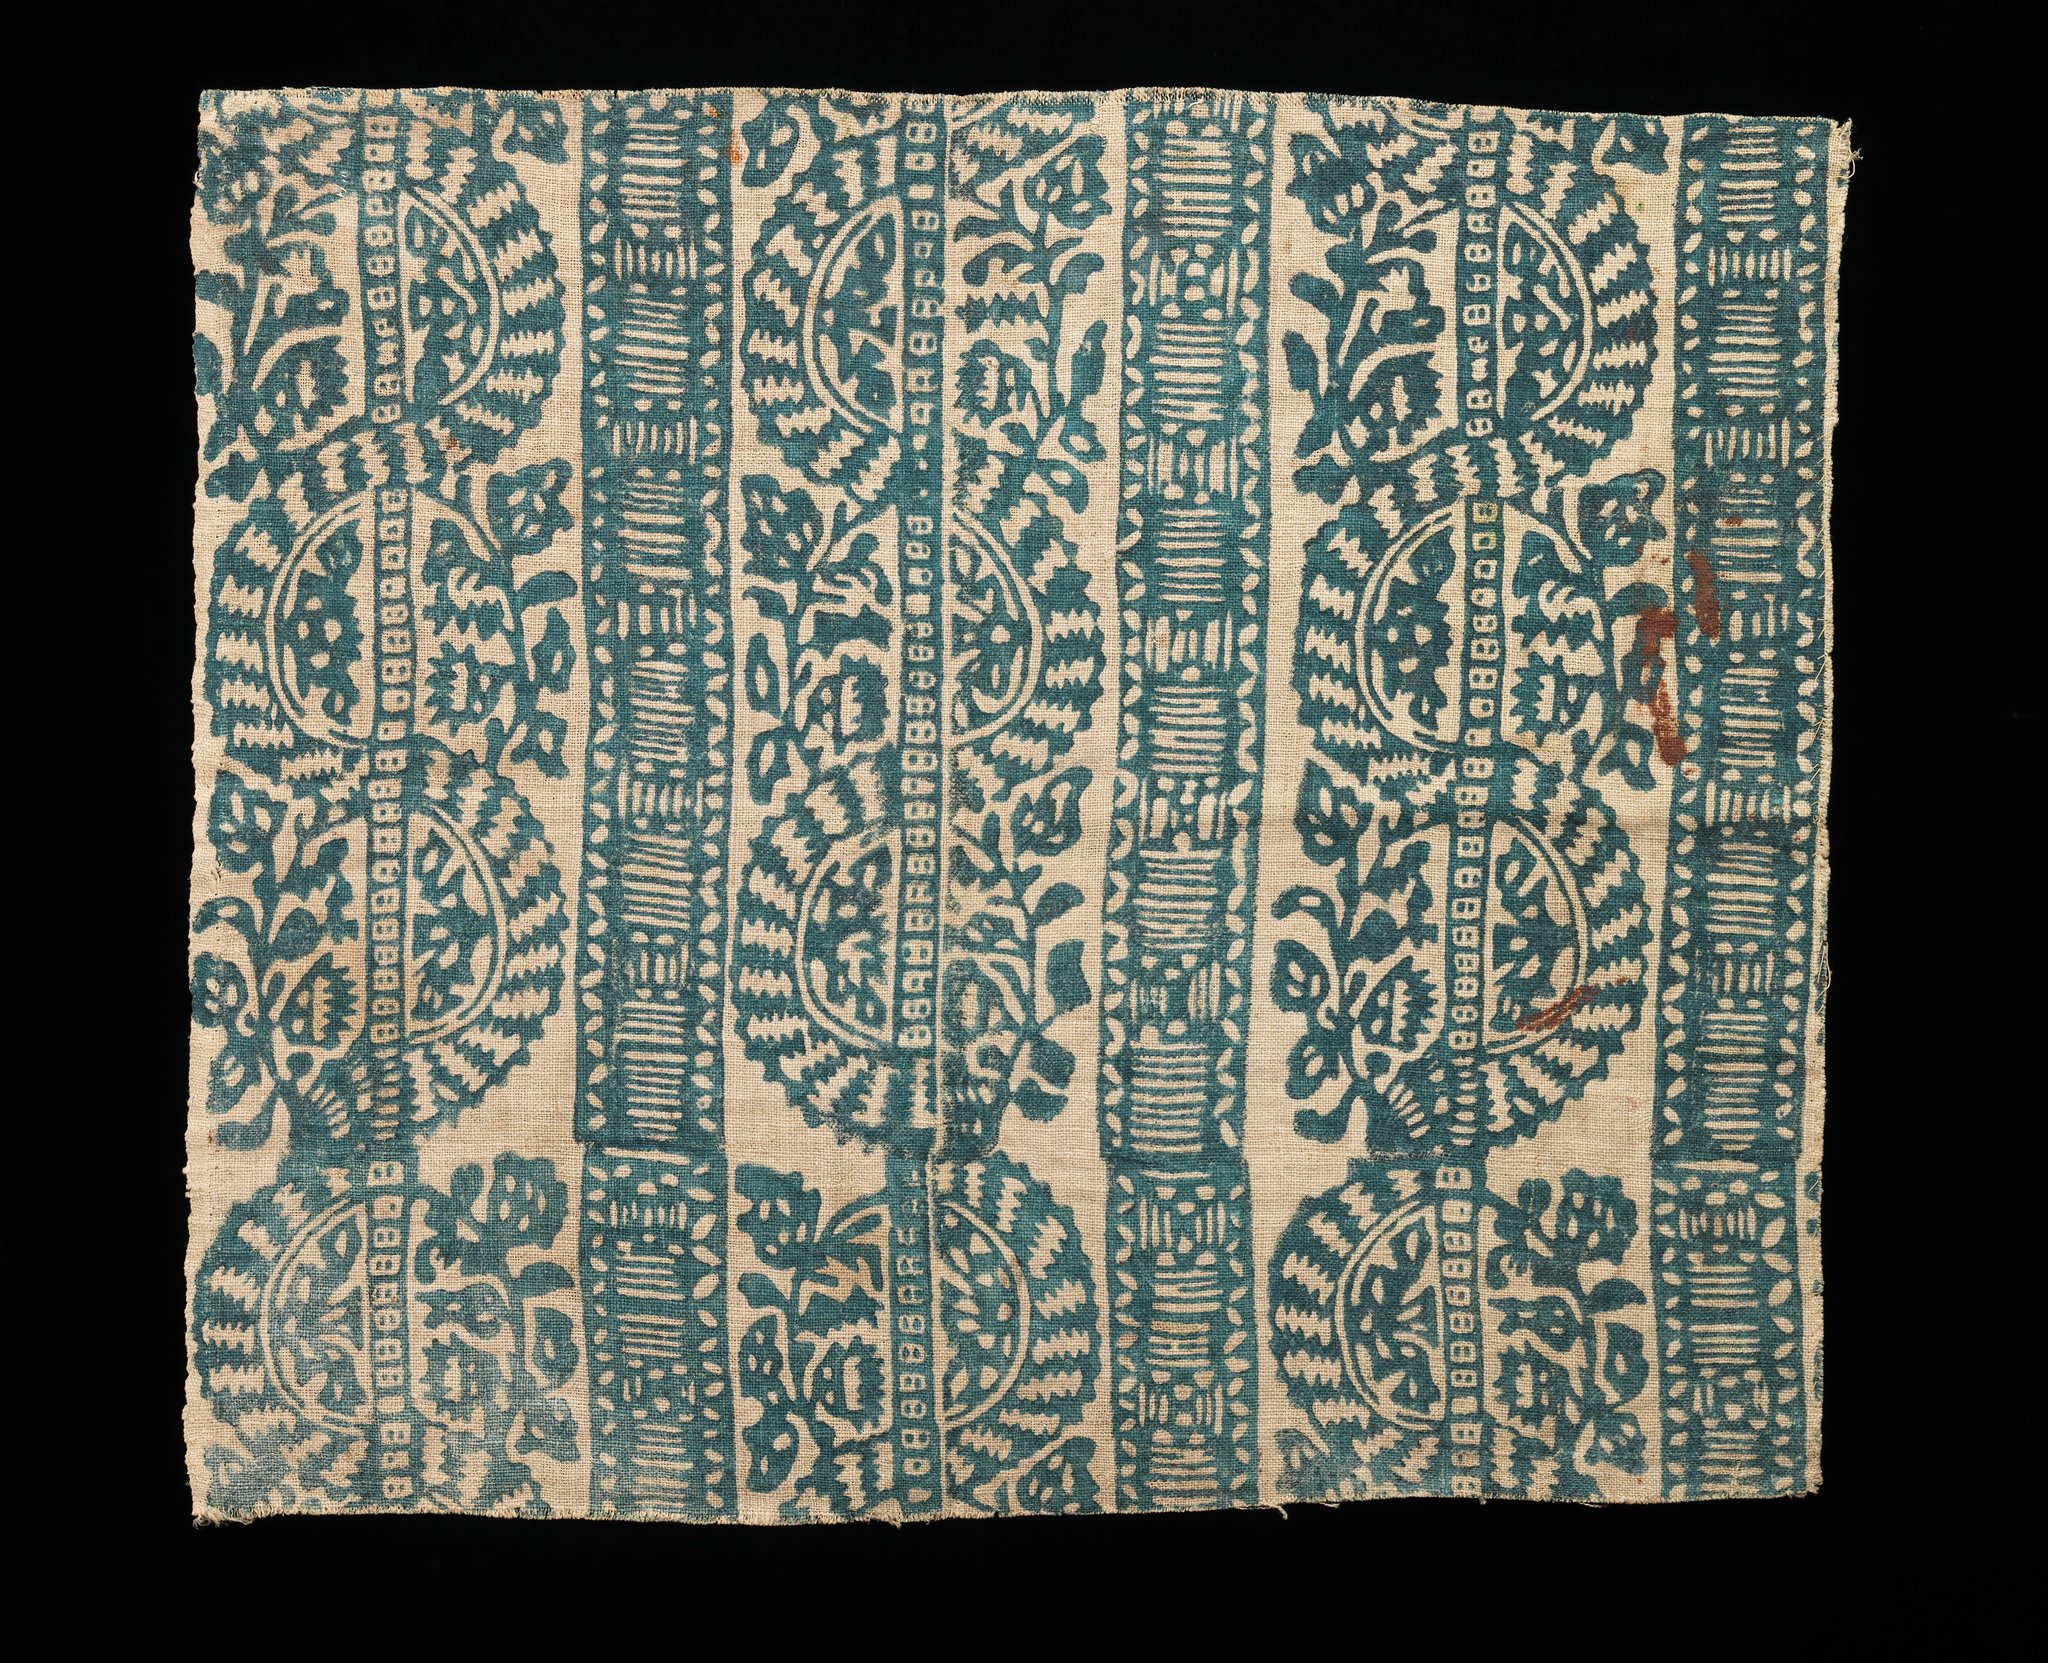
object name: textile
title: Textile fragment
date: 1700-1899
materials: linen